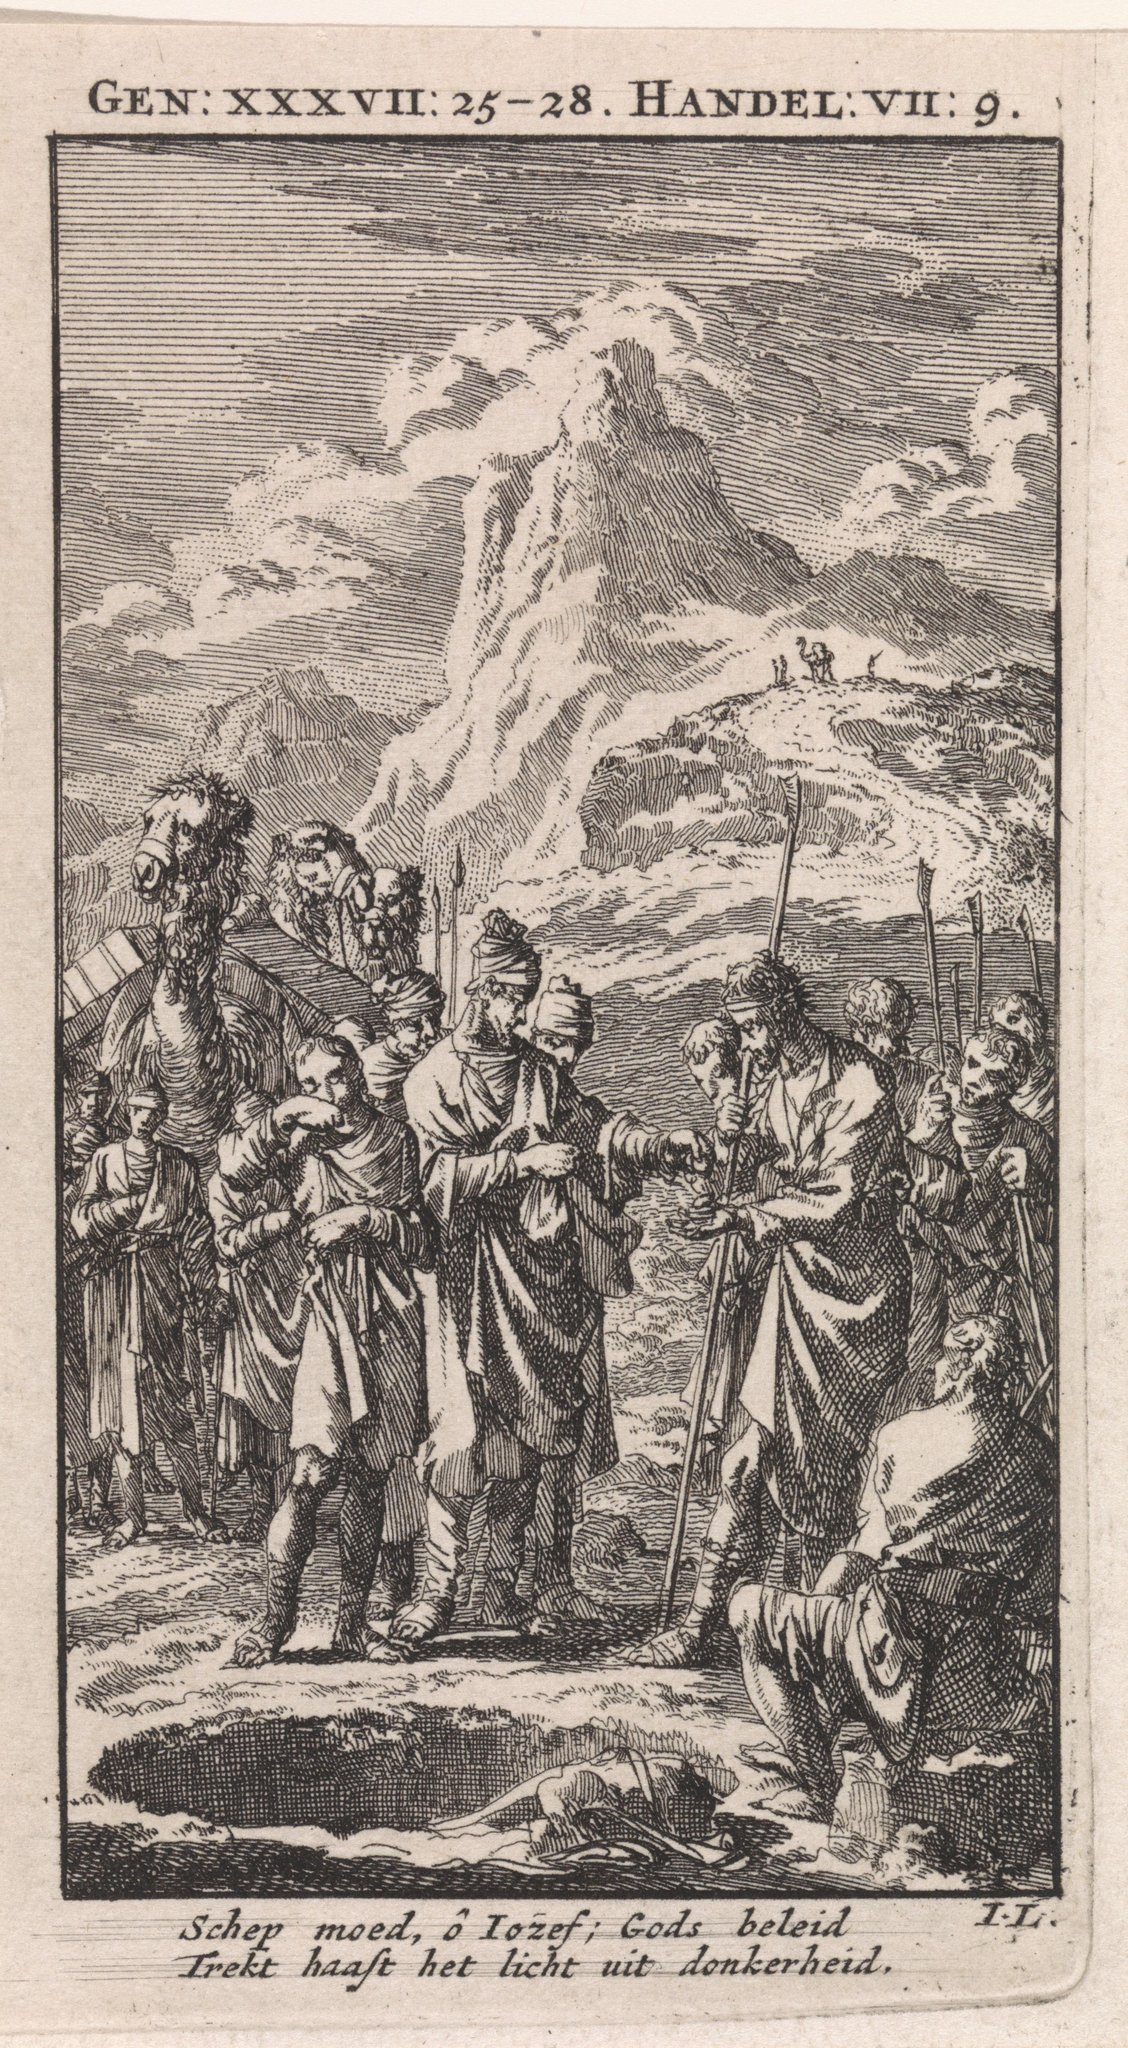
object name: print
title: Jozef wordt door zijn broers verkocht aan kooplieden bij de put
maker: jan luyken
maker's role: draughtsman, print maker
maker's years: 1649-1712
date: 1712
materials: paper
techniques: etching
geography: amsterdam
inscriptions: collector's mark: Lugt 2228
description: Illustratie voor: Luyken, Jan. Bybel printen. Amsterdam: Pieter Arentsz. II (wed.) en Cornelis van der Sys, 1712, p. 5.